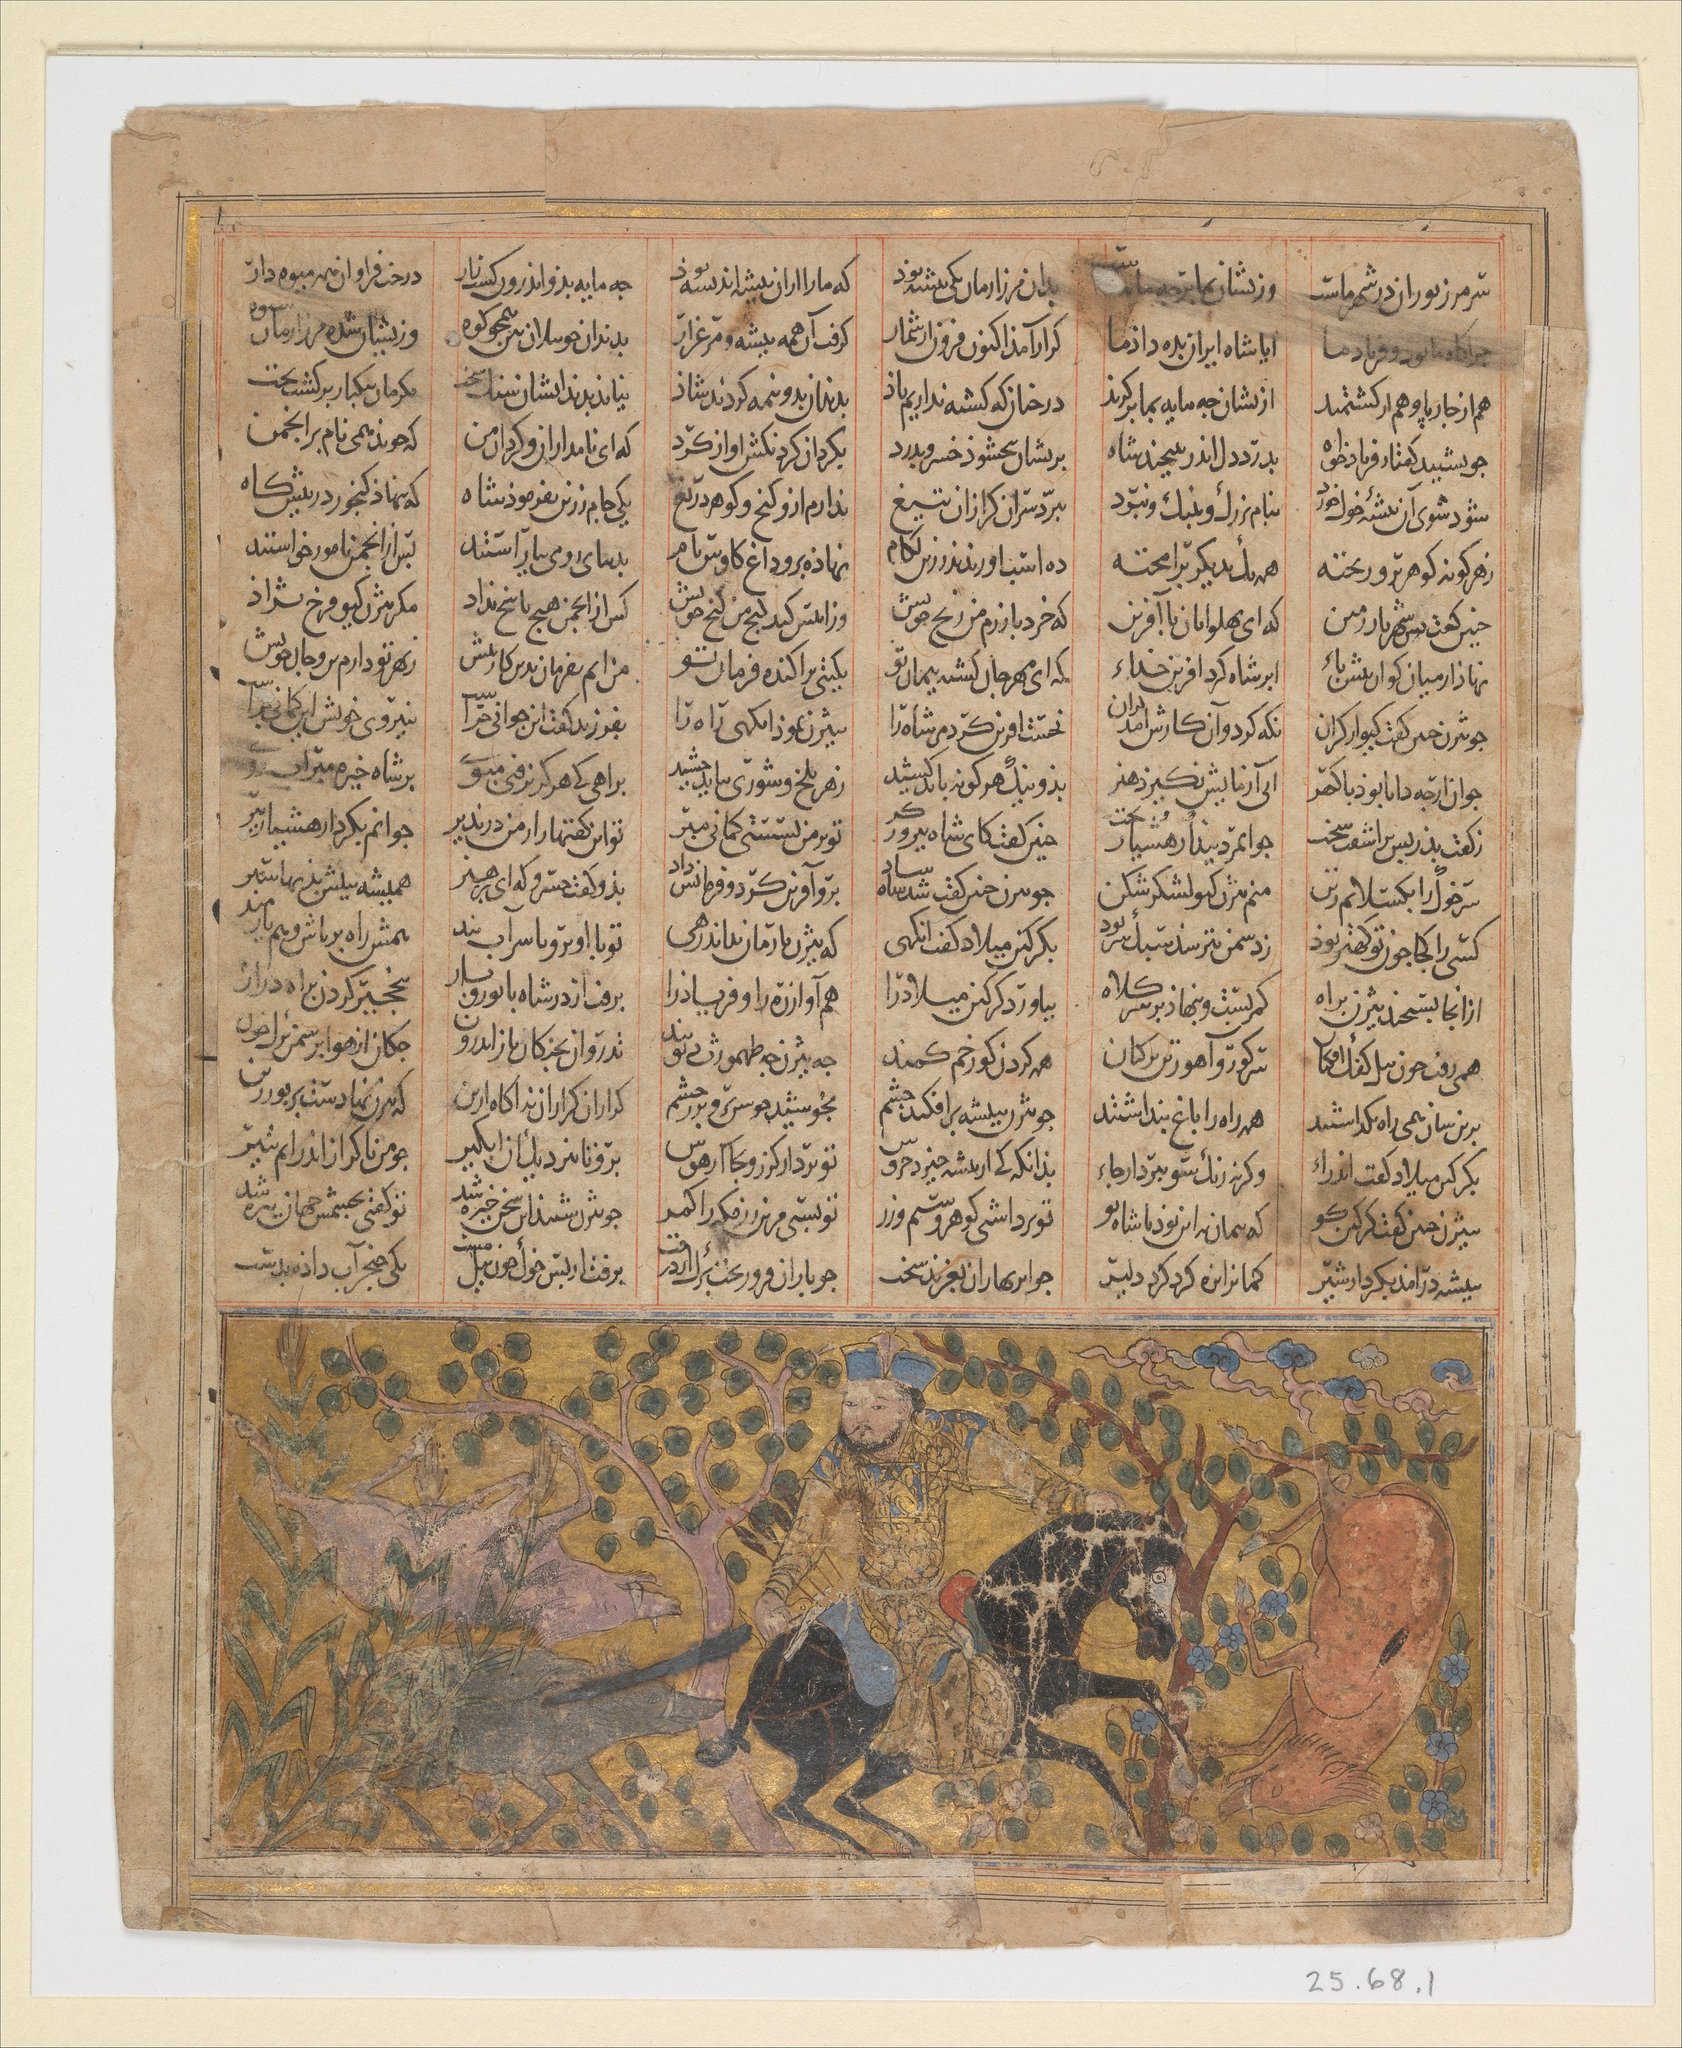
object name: folio from an illustrated manuscript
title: "Bizhan Slaughters the Wild Boars of Irman", Folio from a Shahnama (Book of Kings)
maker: abu'l qasim firdausi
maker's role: author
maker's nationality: iranian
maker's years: 935-1020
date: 1300-1330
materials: gold, ink, paper, watercolor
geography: iraq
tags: men,hunting,boars,horses